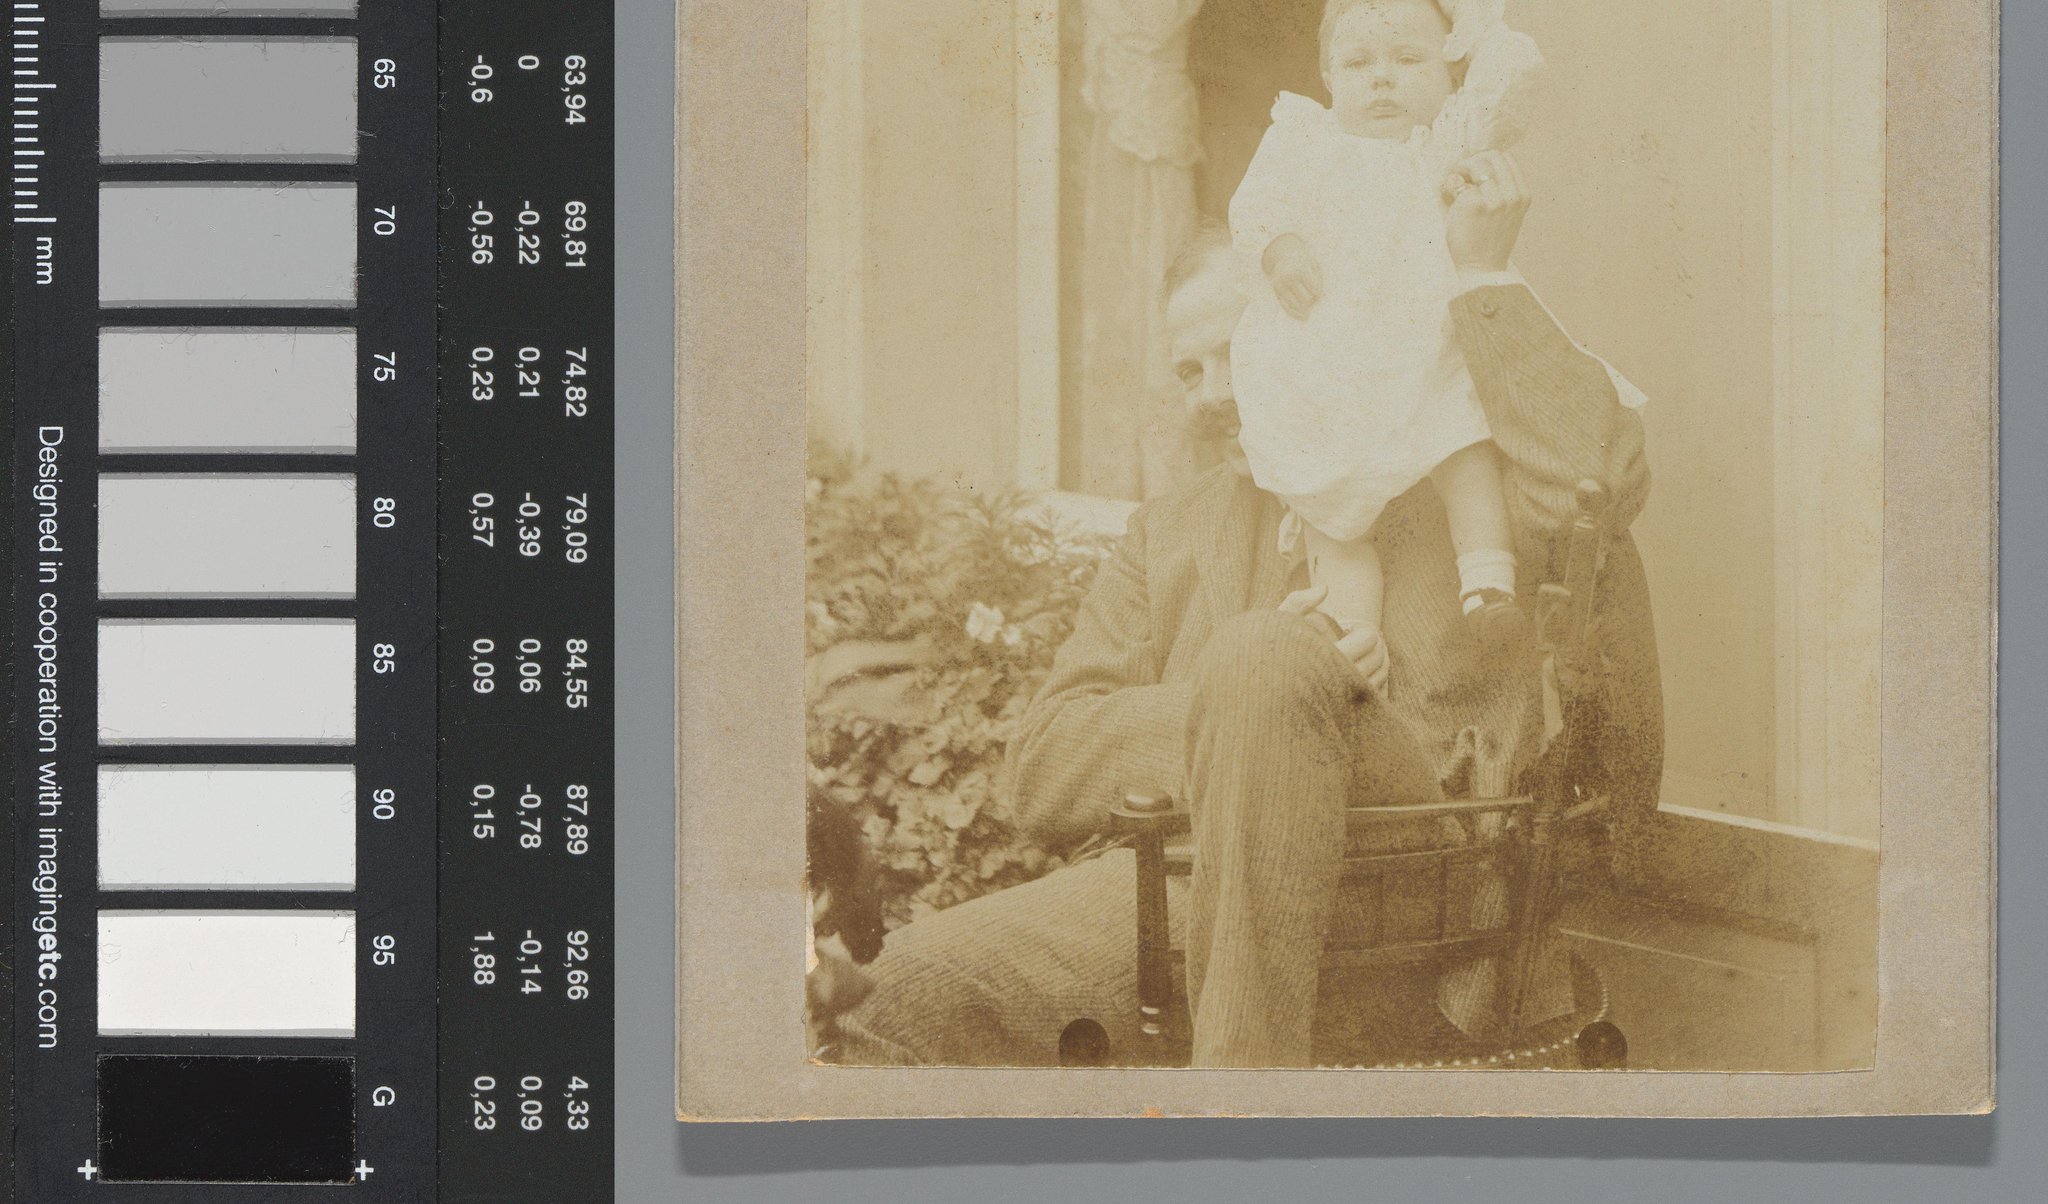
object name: photograph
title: Karel Frederik van den Berg zittend met een baby in zijn armen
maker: Anonymous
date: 1895-1915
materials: cardboard, photographic support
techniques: albumen print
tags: batavia, karel frederik van den berg